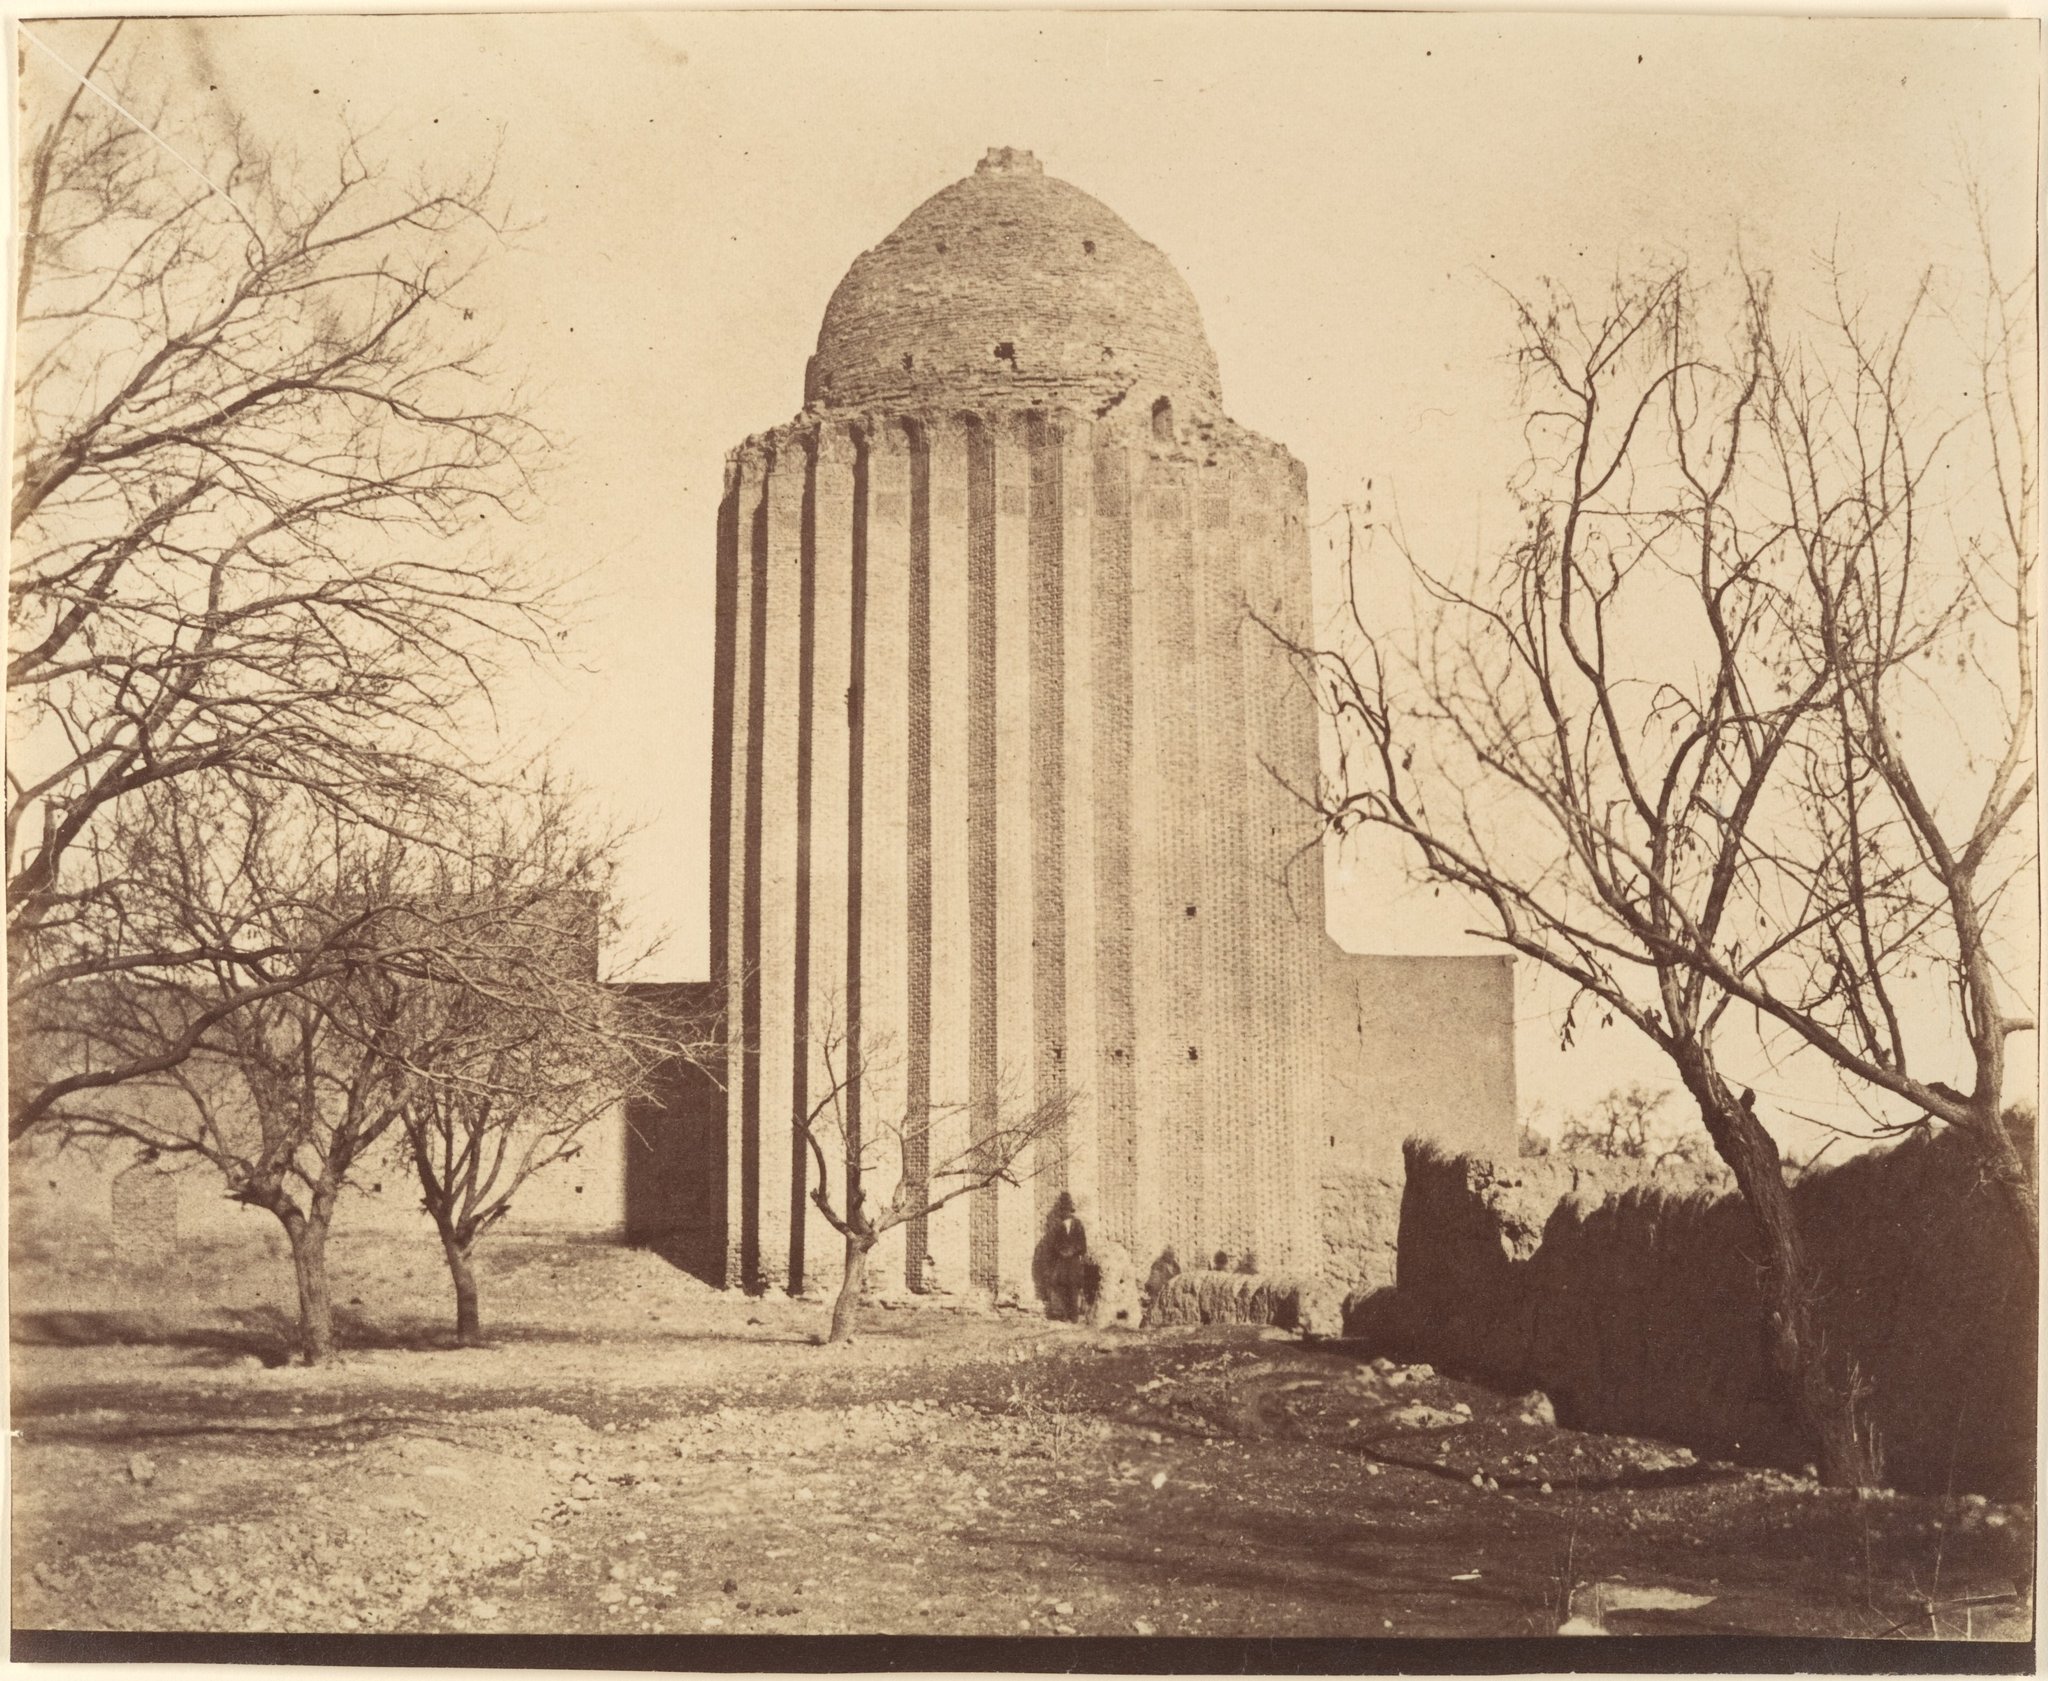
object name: photograph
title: [Bastam, Tomb Tower (built 1313), Khorasan]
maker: luigi pesce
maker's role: artist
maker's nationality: italian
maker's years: 1818-1891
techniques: albumen silver print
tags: architecture,tombs,towers